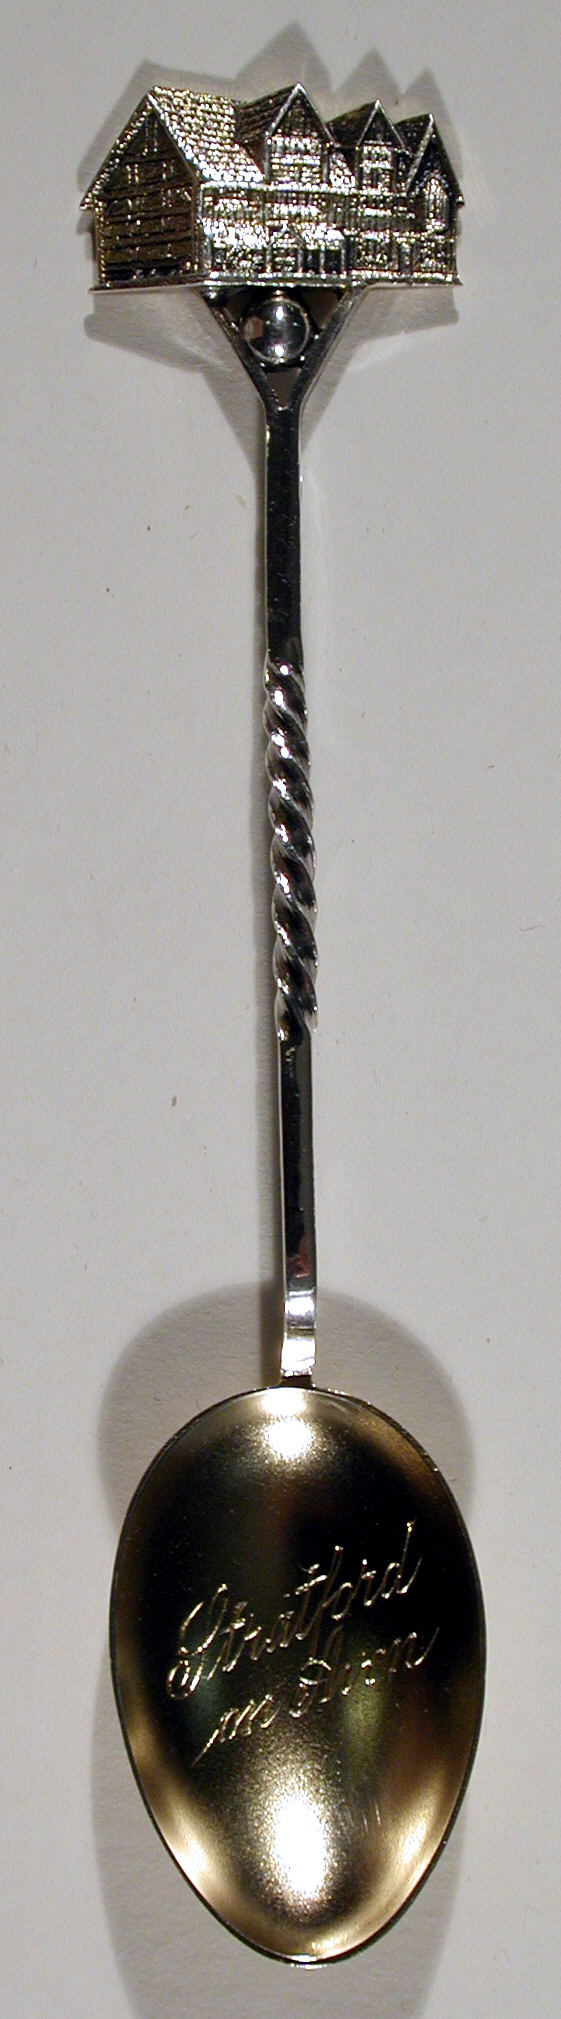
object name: souvenir spoon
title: Souvenir spoon with finial in form of William Shakespeare's house in Stratford-on-Avon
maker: saunders & shepherd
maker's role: maker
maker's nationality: british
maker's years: 1869-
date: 1867-1900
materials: gilt, silver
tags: houses